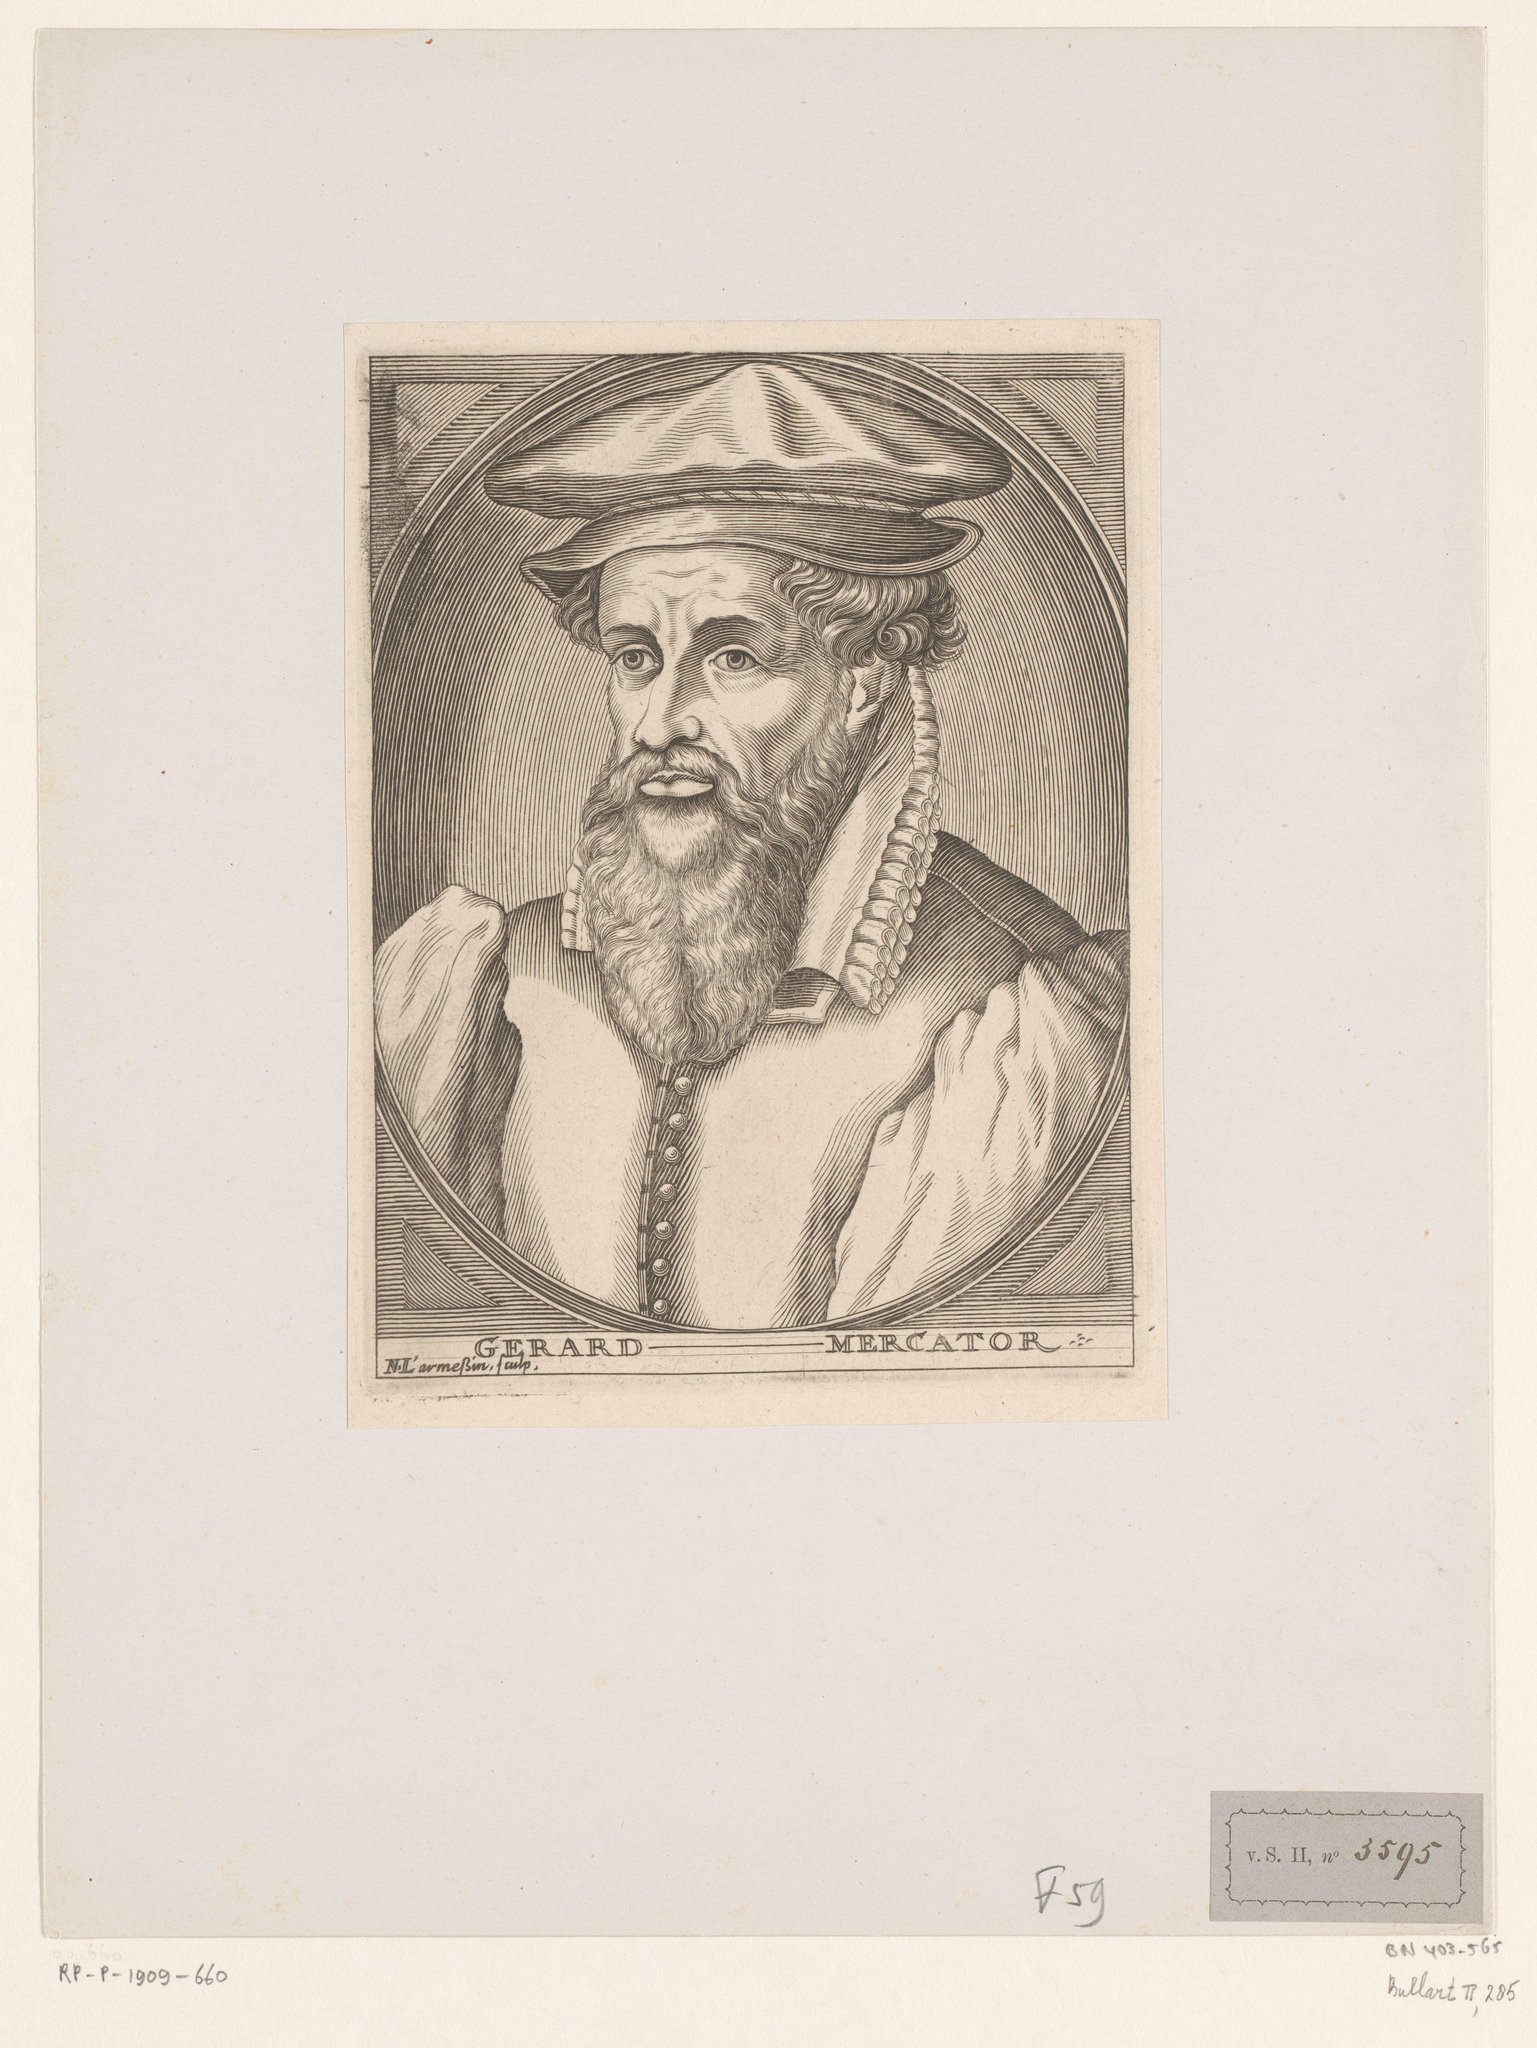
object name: book illustration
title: Portret van Gerardus Mercator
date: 1682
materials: paper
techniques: engraving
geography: brussels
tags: instrument maker, gerardus mercator, historical persons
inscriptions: collector's mark: Lugt 2228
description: Prent gebruikt voor: Bullart, Isaac. Académie des Sciences et Arts contenant les vies et éloges his. des hommes illustres qui ont excellé en ces professions depuis environ quatre siècles. Brussel: François Foppens, 1682. Het boek werd in 1682 eveneens in Amsterdam uitgegeven door de erfgenamen van Daniel Elzevier. Ieder portret betreft een illustratie bij de biografie van een kunstenaar of geleerde. De meeste portretten werden door Nicolas de Larmessin vervaardigd (162), 93 door De Boulonois en een derde door ongeïdentificeerde prentmakers. Dit betreft een illustratie op p. 285, deel II.